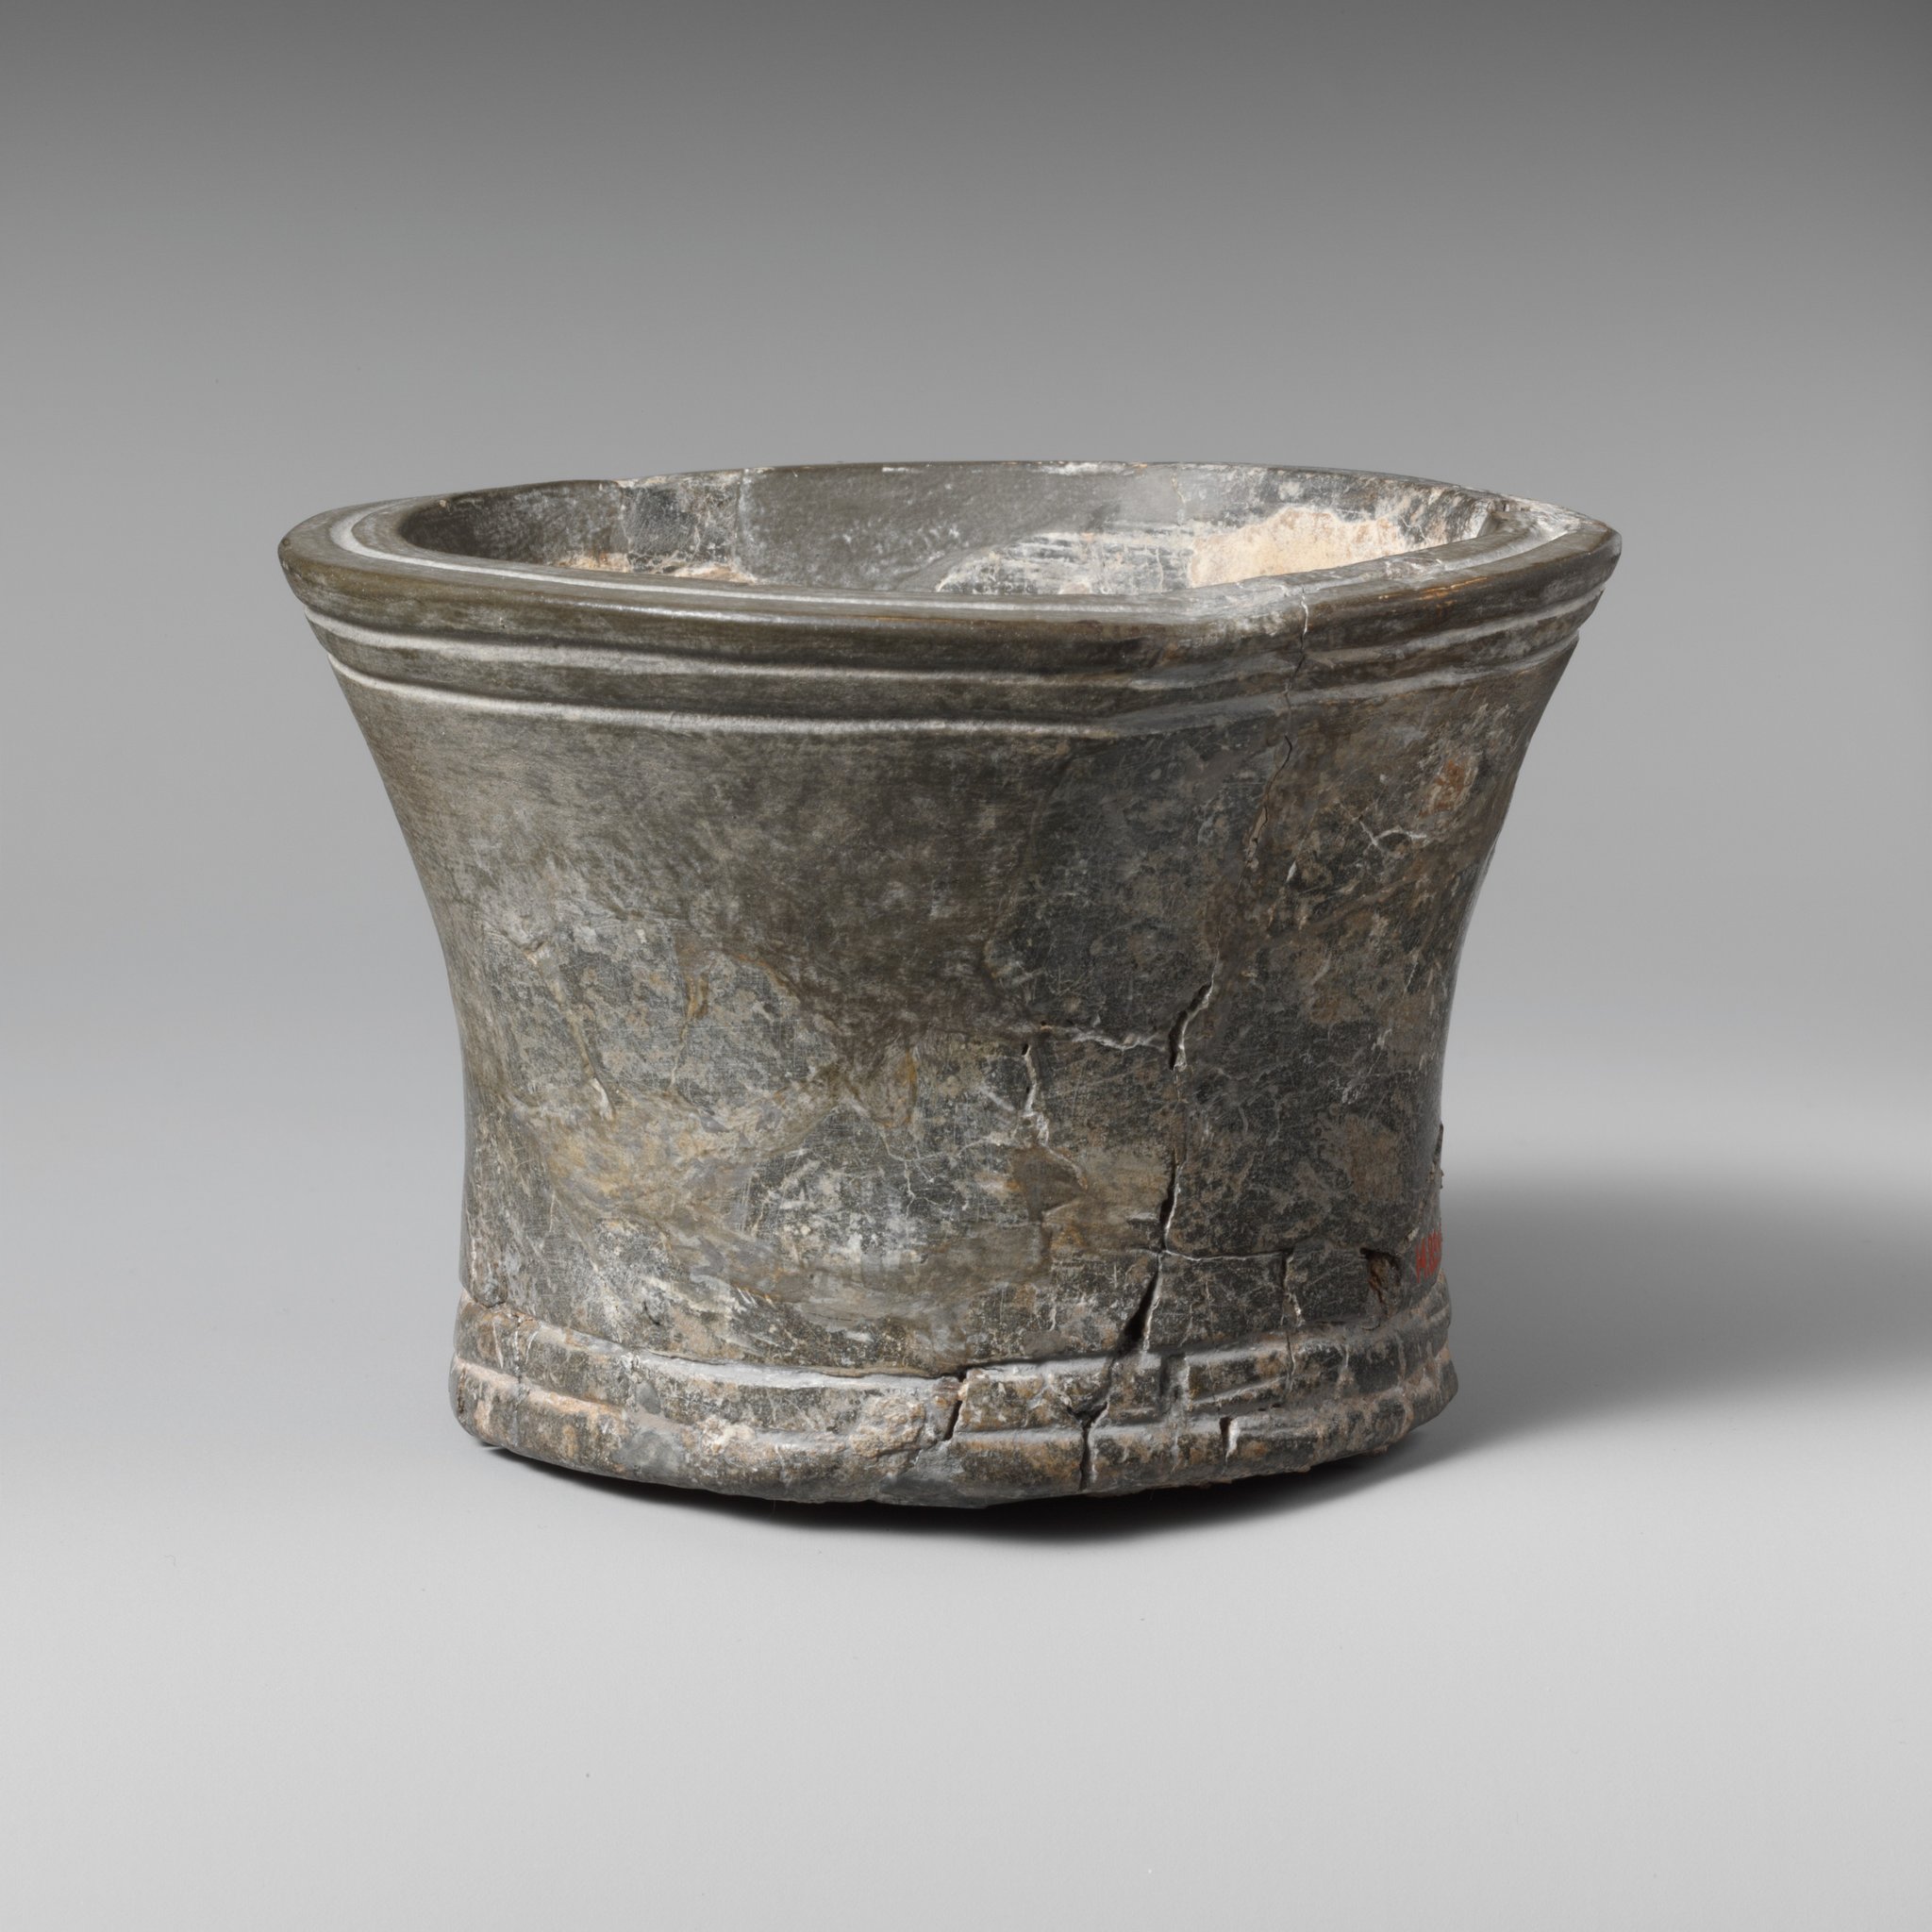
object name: cup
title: Serpentine tankard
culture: minoan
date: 1750-1450 BCE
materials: stone